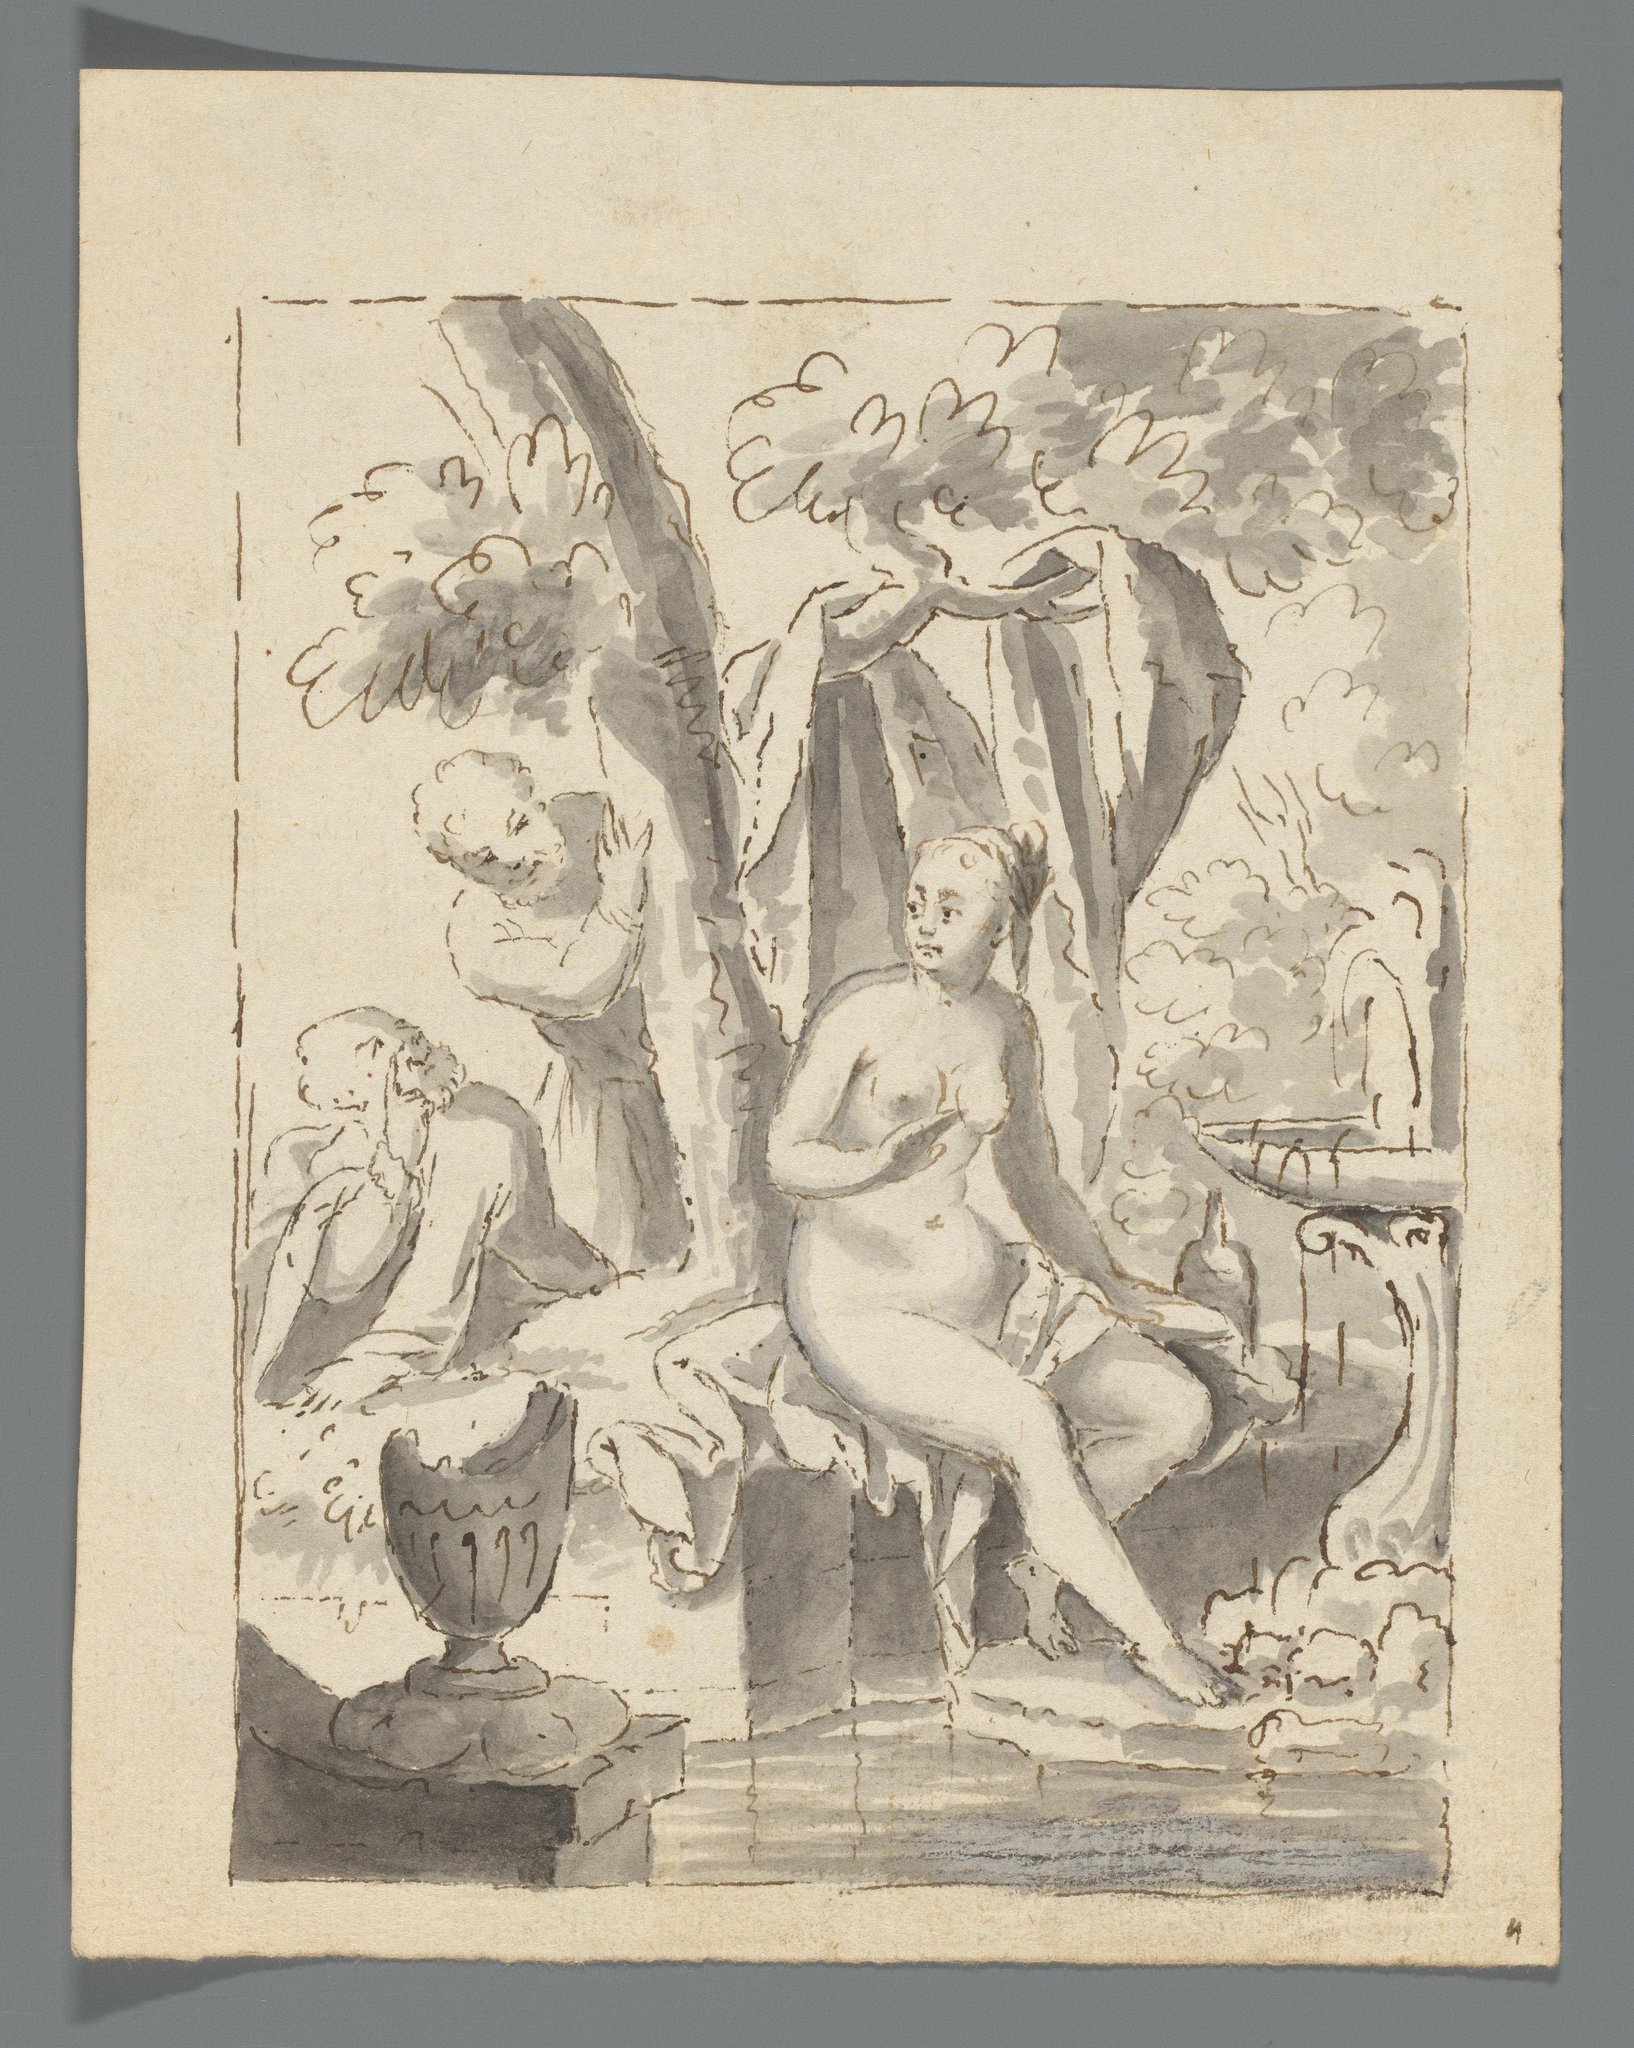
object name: drawing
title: Susanna en de ouderlingen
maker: matthijs balen (1684-1766)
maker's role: draughtsman, painter, print maker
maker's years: 1684-1766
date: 1694-1766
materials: paint, paper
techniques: brush, pen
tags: the elders spying upon susanna